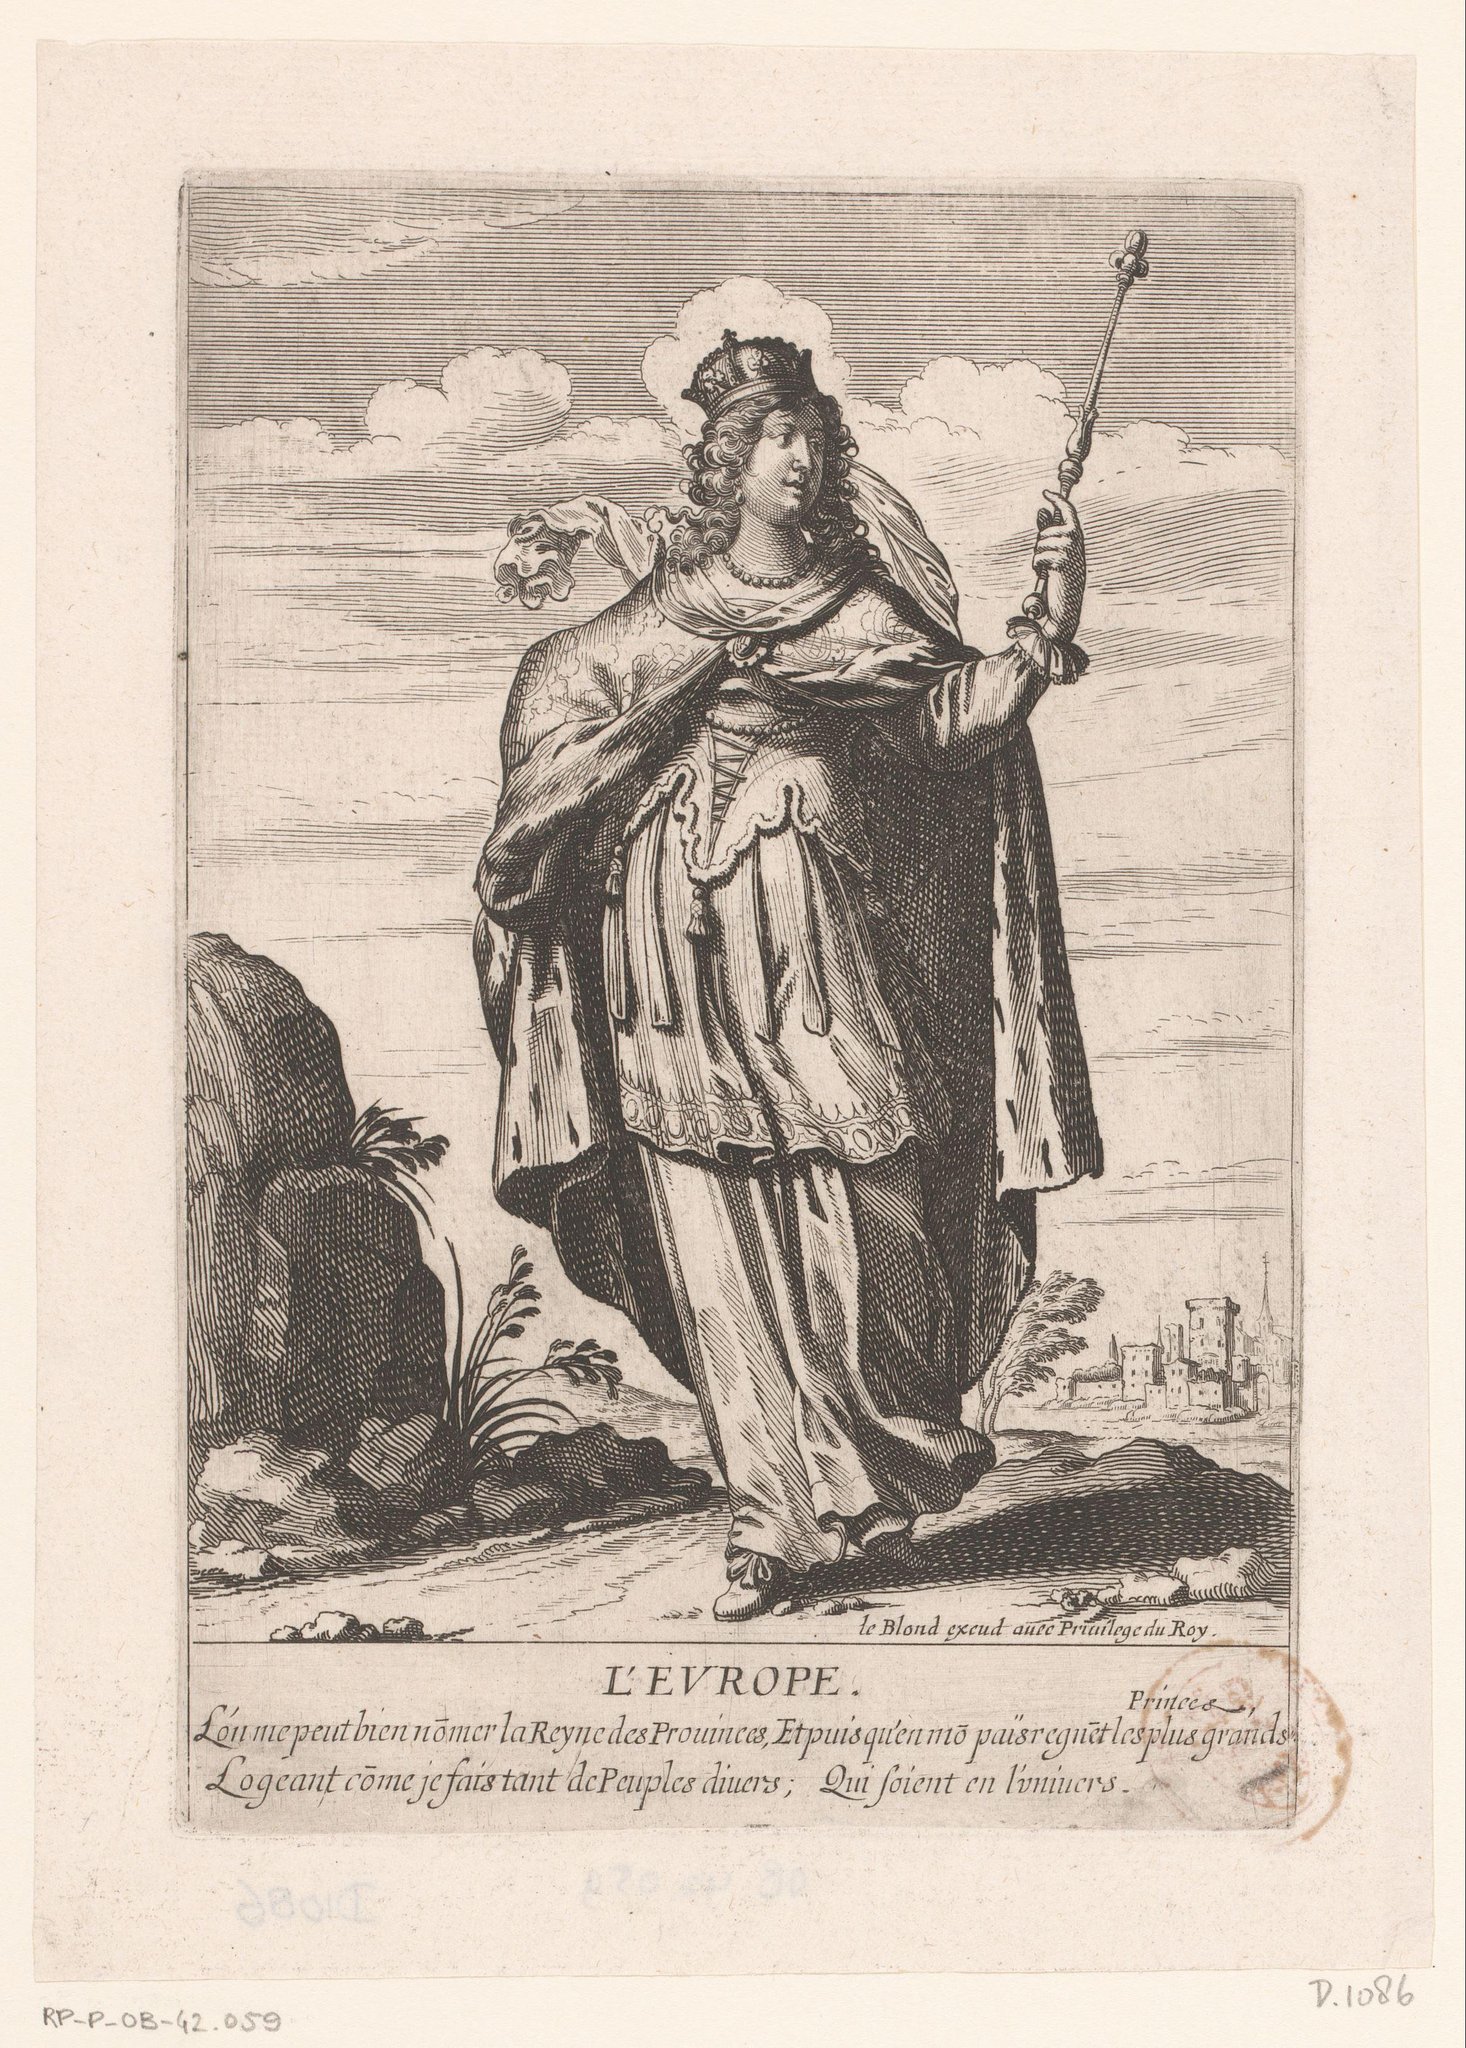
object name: print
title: Europa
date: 1612-1666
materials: paper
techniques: engraving, etching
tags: europe represented allegorically; 'europa' (ripa), queen, continents represented allegorically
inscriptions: collector's mark: Lugt 240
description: Maakt deel uit van een vierdelige serie met personificaties van de vier continenten.